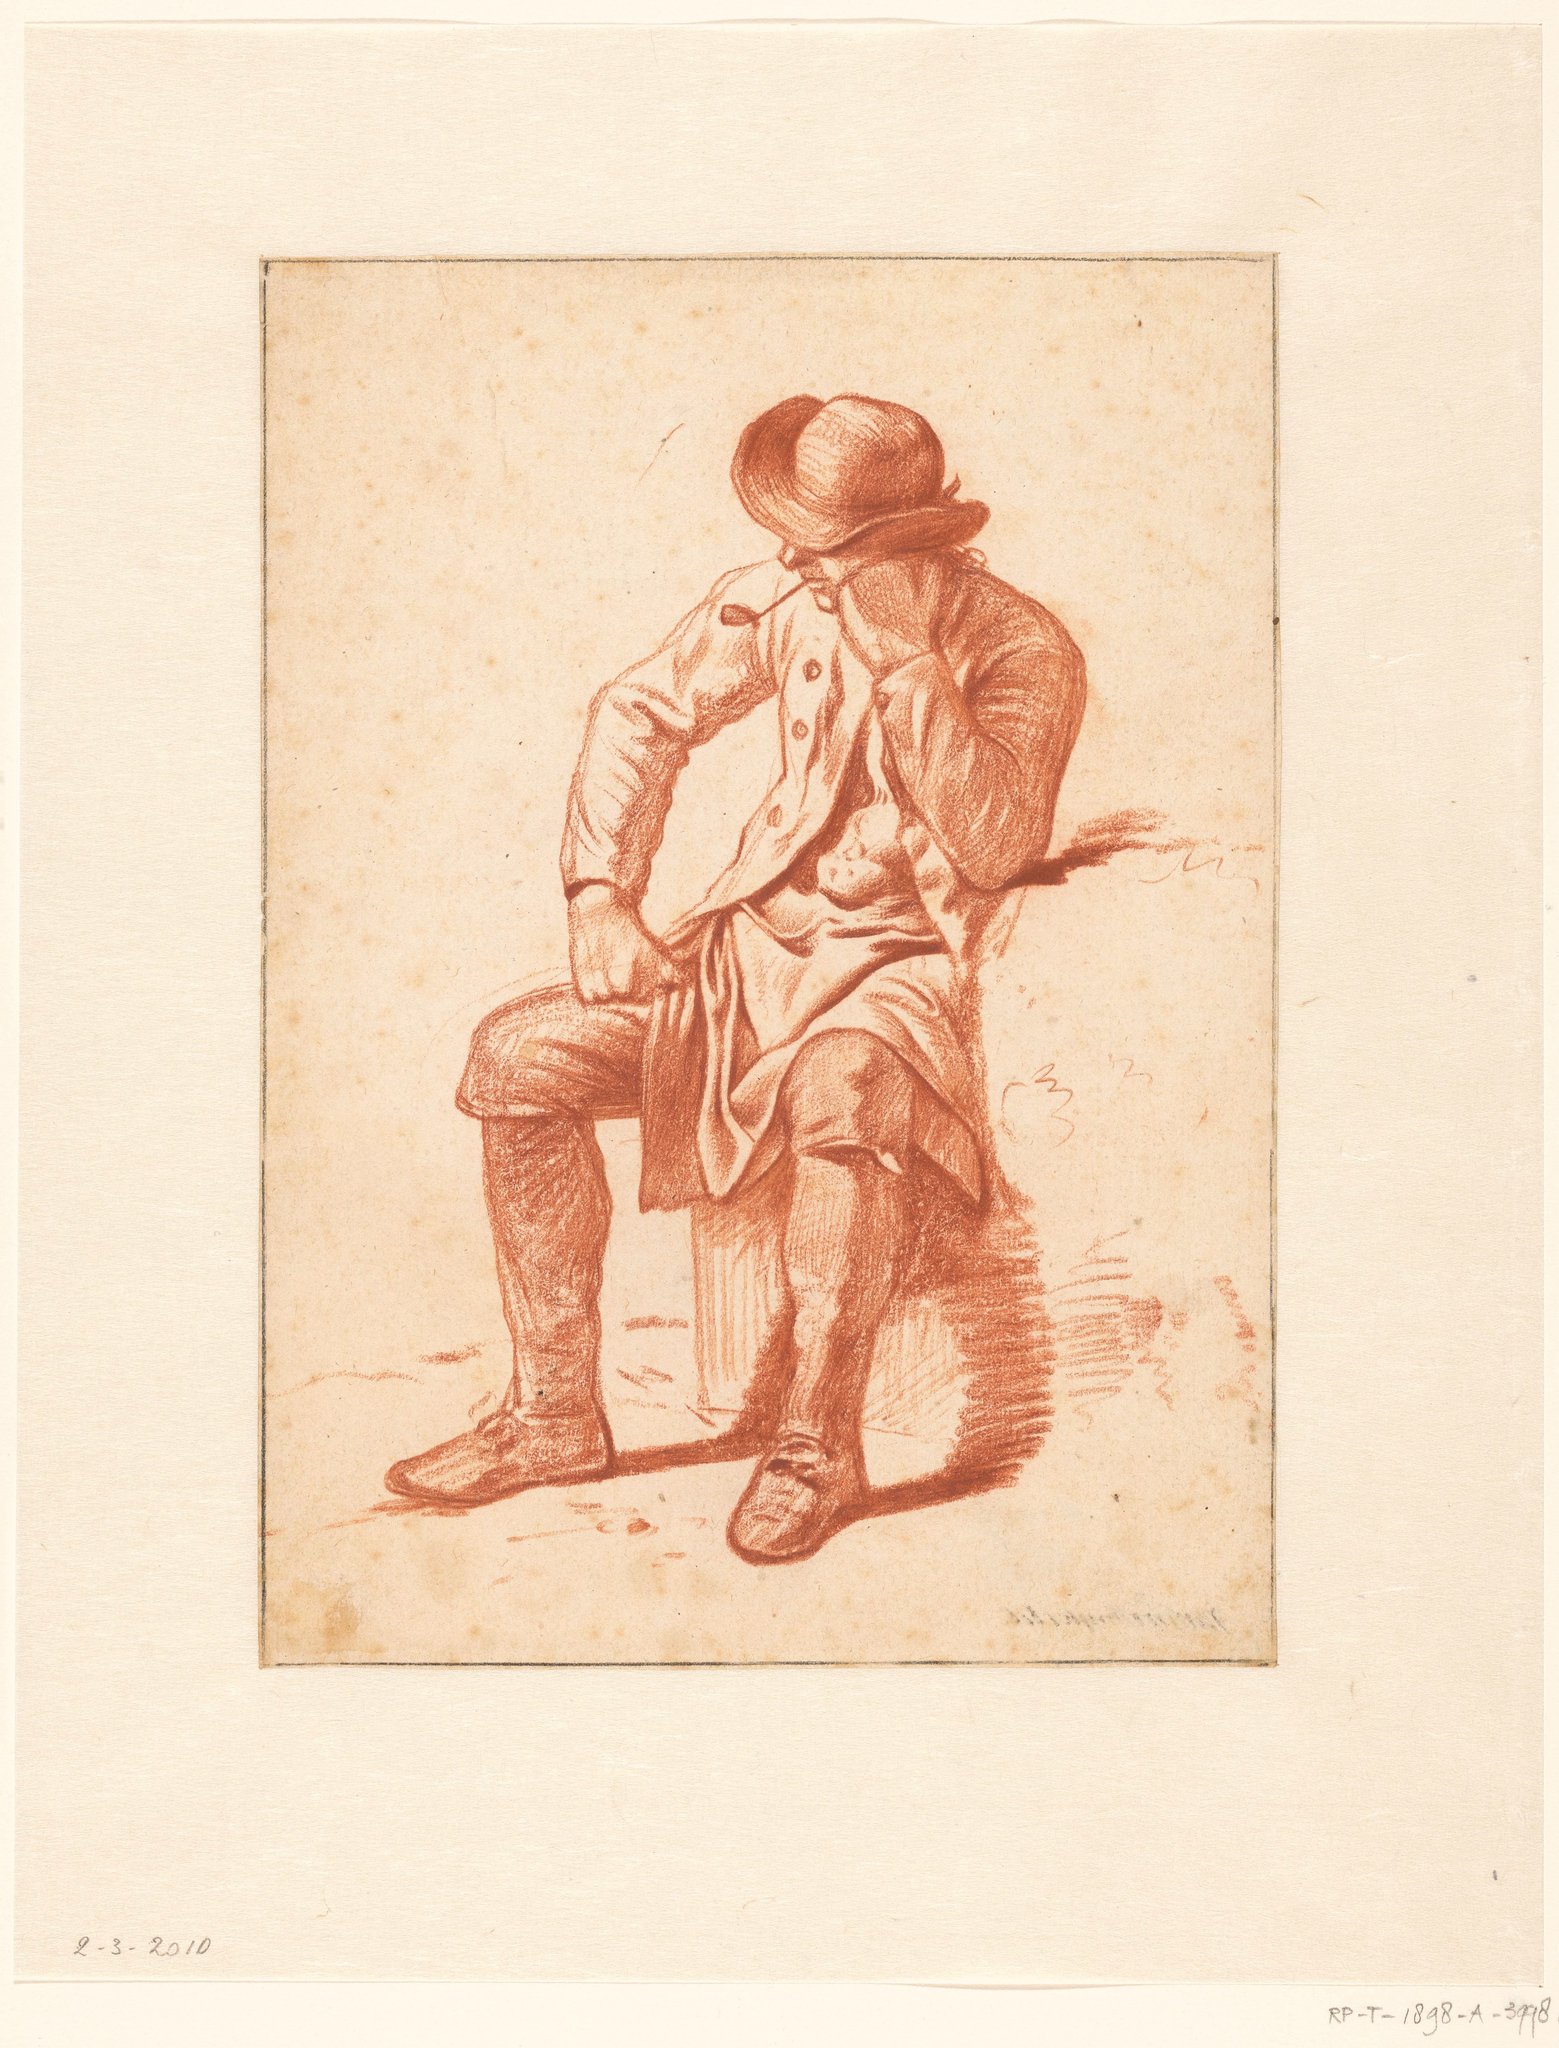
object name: drawing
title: Zittende boer die pijp rookt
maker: wouter johannes van troostwijk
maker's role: draughtsman, painter, print maker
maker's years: 1782-1810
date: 1806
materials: chalk, paper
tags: pipe ~ tobacco